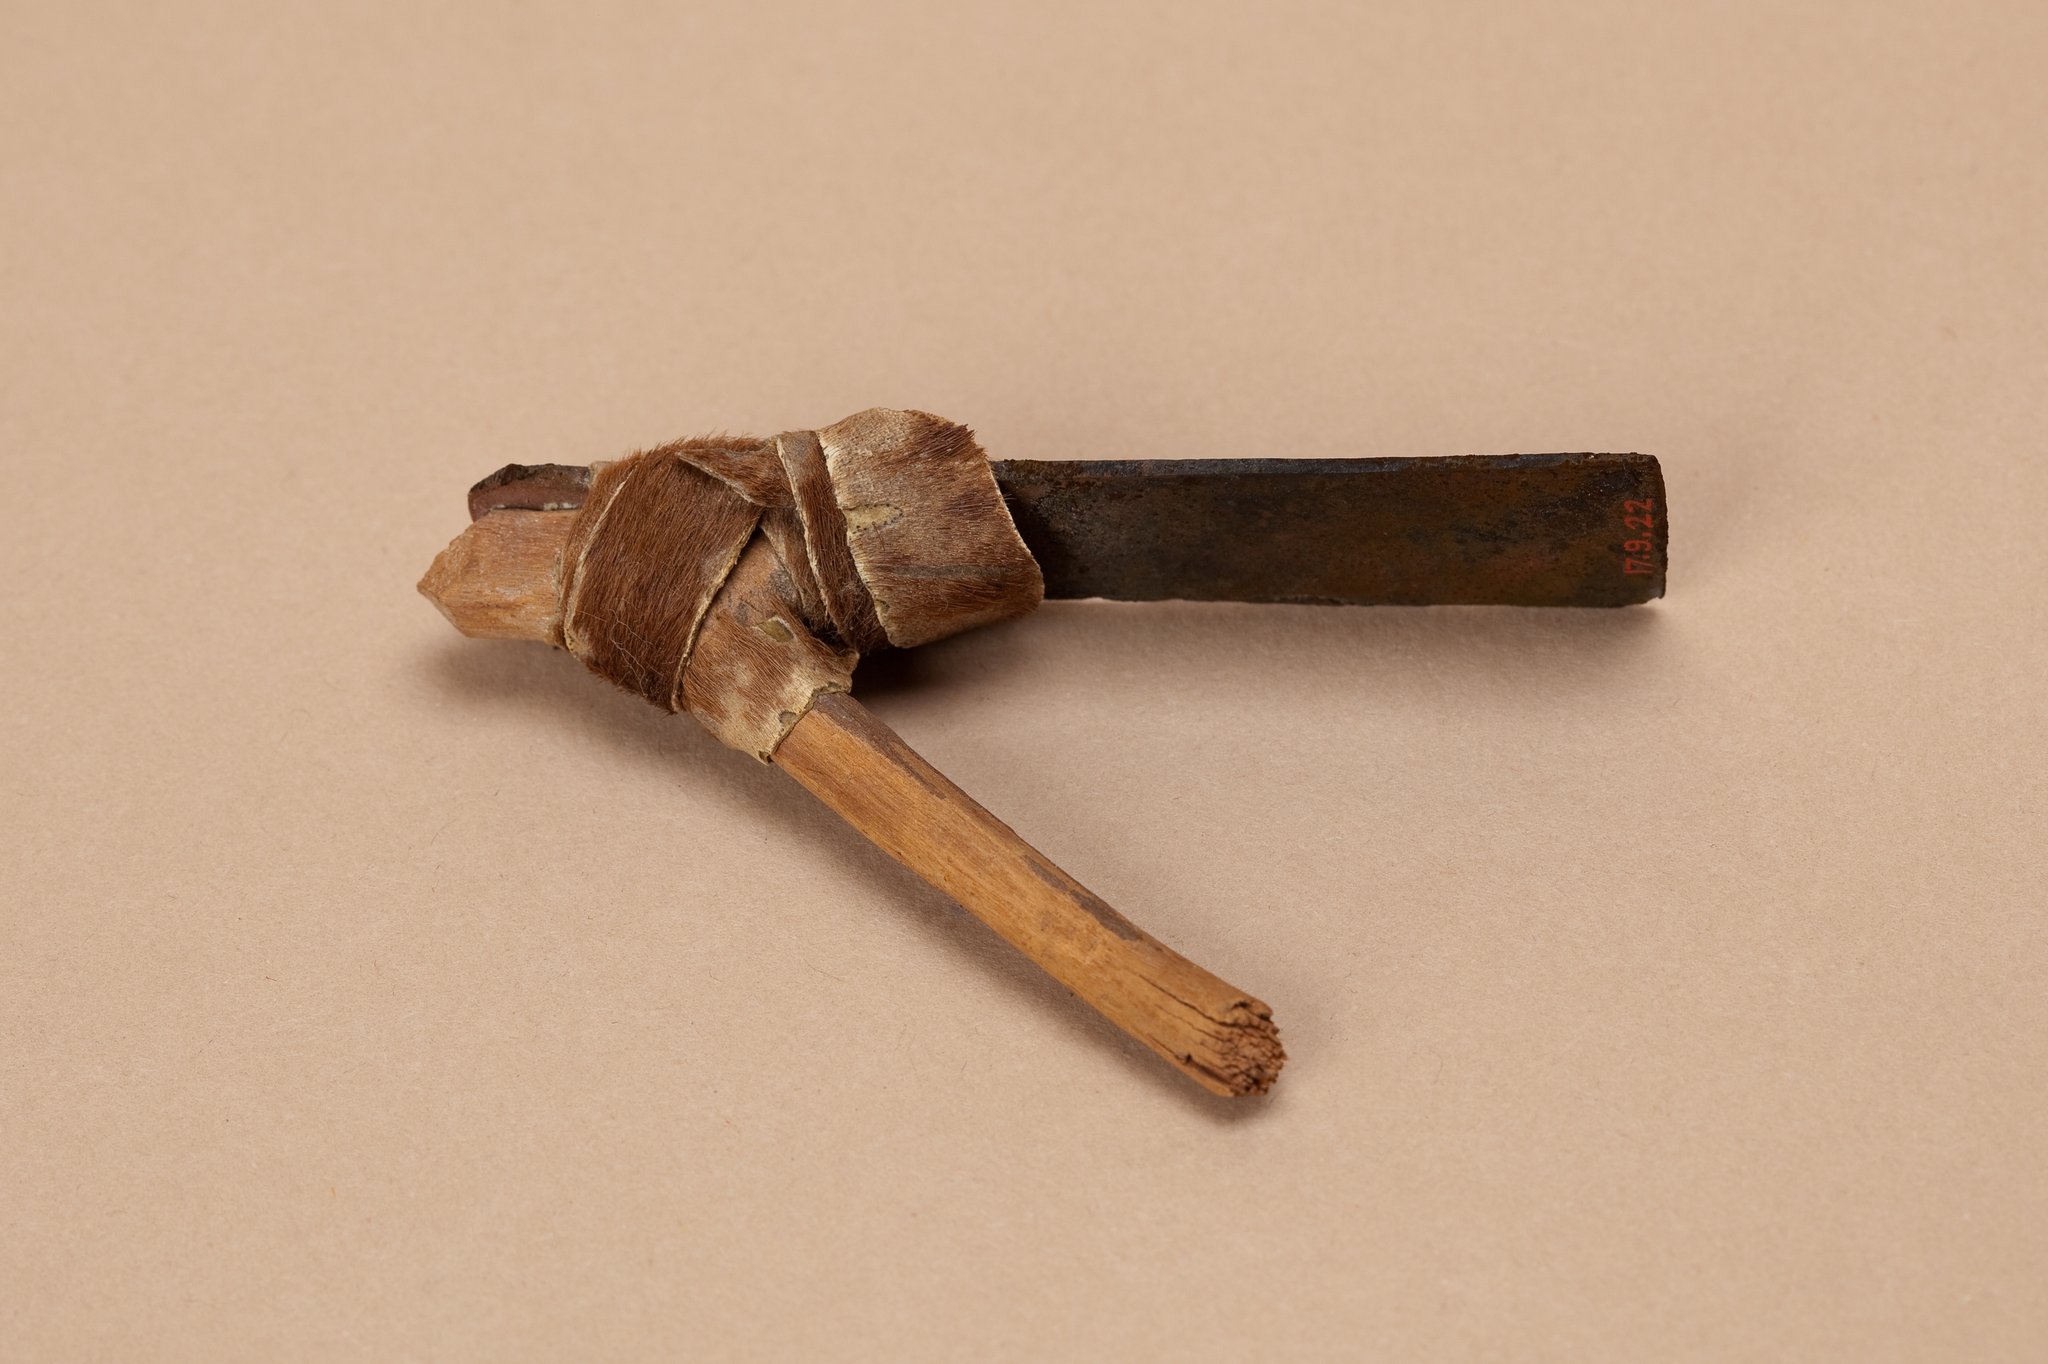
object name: model adze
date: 1981-1802 BCE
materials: copper, wood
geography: egypt